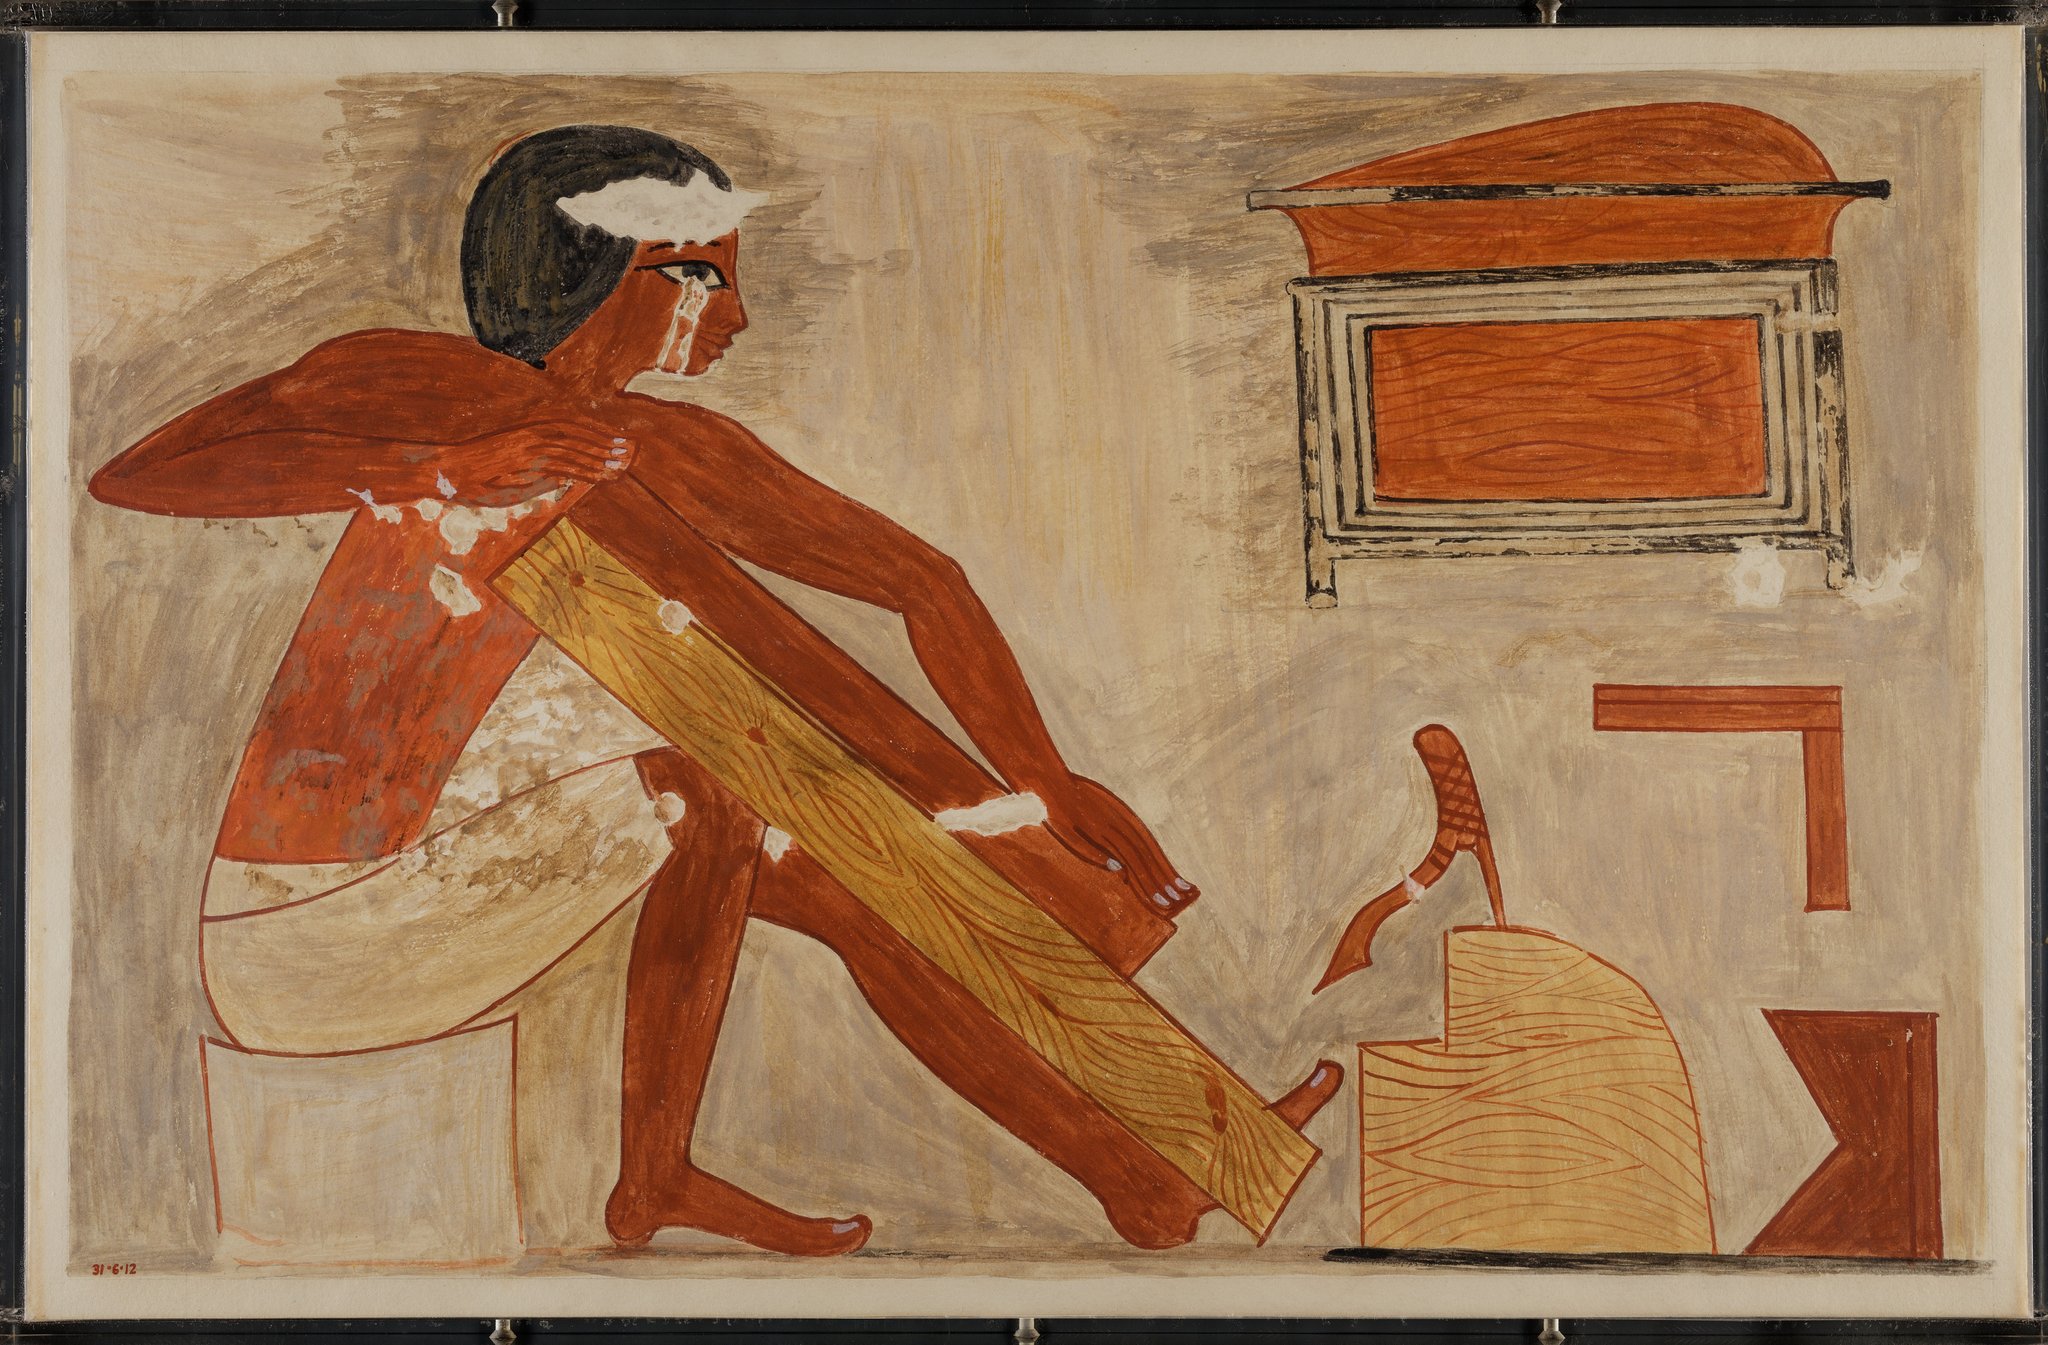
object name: facsimile, rekhmire tt 100, carpenter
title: Carpenter with Tools, Tomb of Rekhmire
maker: nina de garis davies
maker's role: artist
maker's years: 1881-1965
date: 1504-1425 BCE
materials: ink, paint, paper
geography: egypt